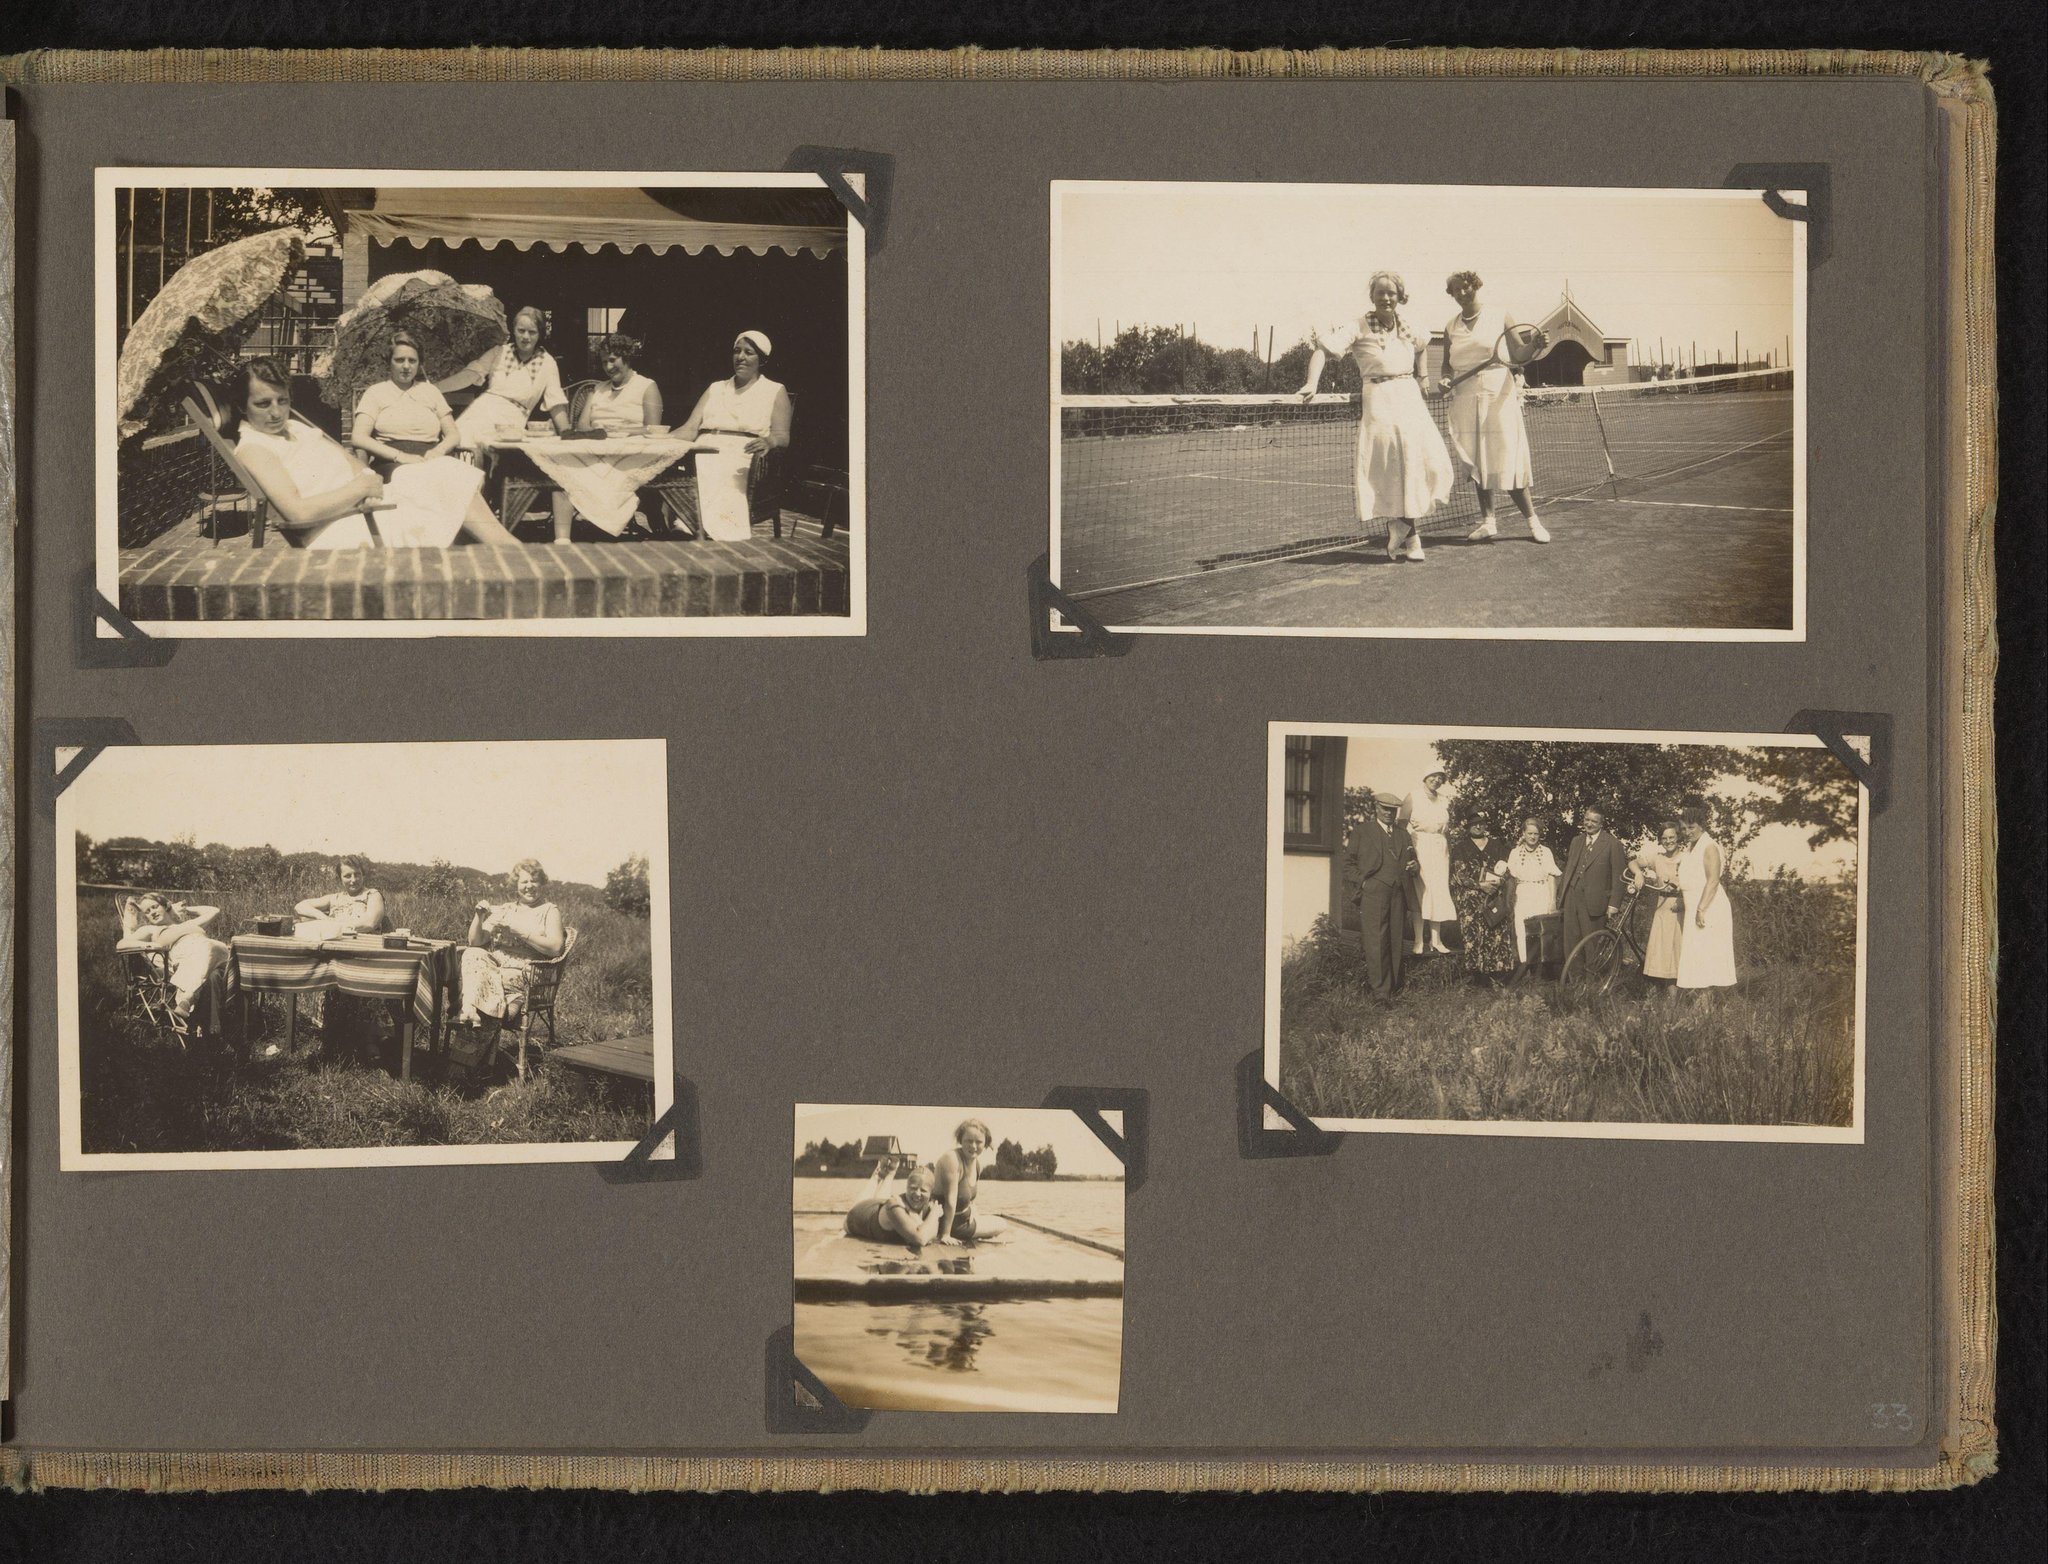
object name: album leaf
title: Vriendinnen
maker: Anonymous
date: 1930-1931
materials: cardboard, photographic support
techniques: gelatin silver print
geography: groningen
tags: tennis, lawn-tennis, (family) meal - cc - out of doors, groningen (province)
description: Albumblad met vijf foto's met vriendinnen op de tennisclub (Groninger Lawn Tennis Bond), buiten aan een tafel en in badpak aan het water. Onderdeel van fotoalbum 'Studentenalbum Indologen'.